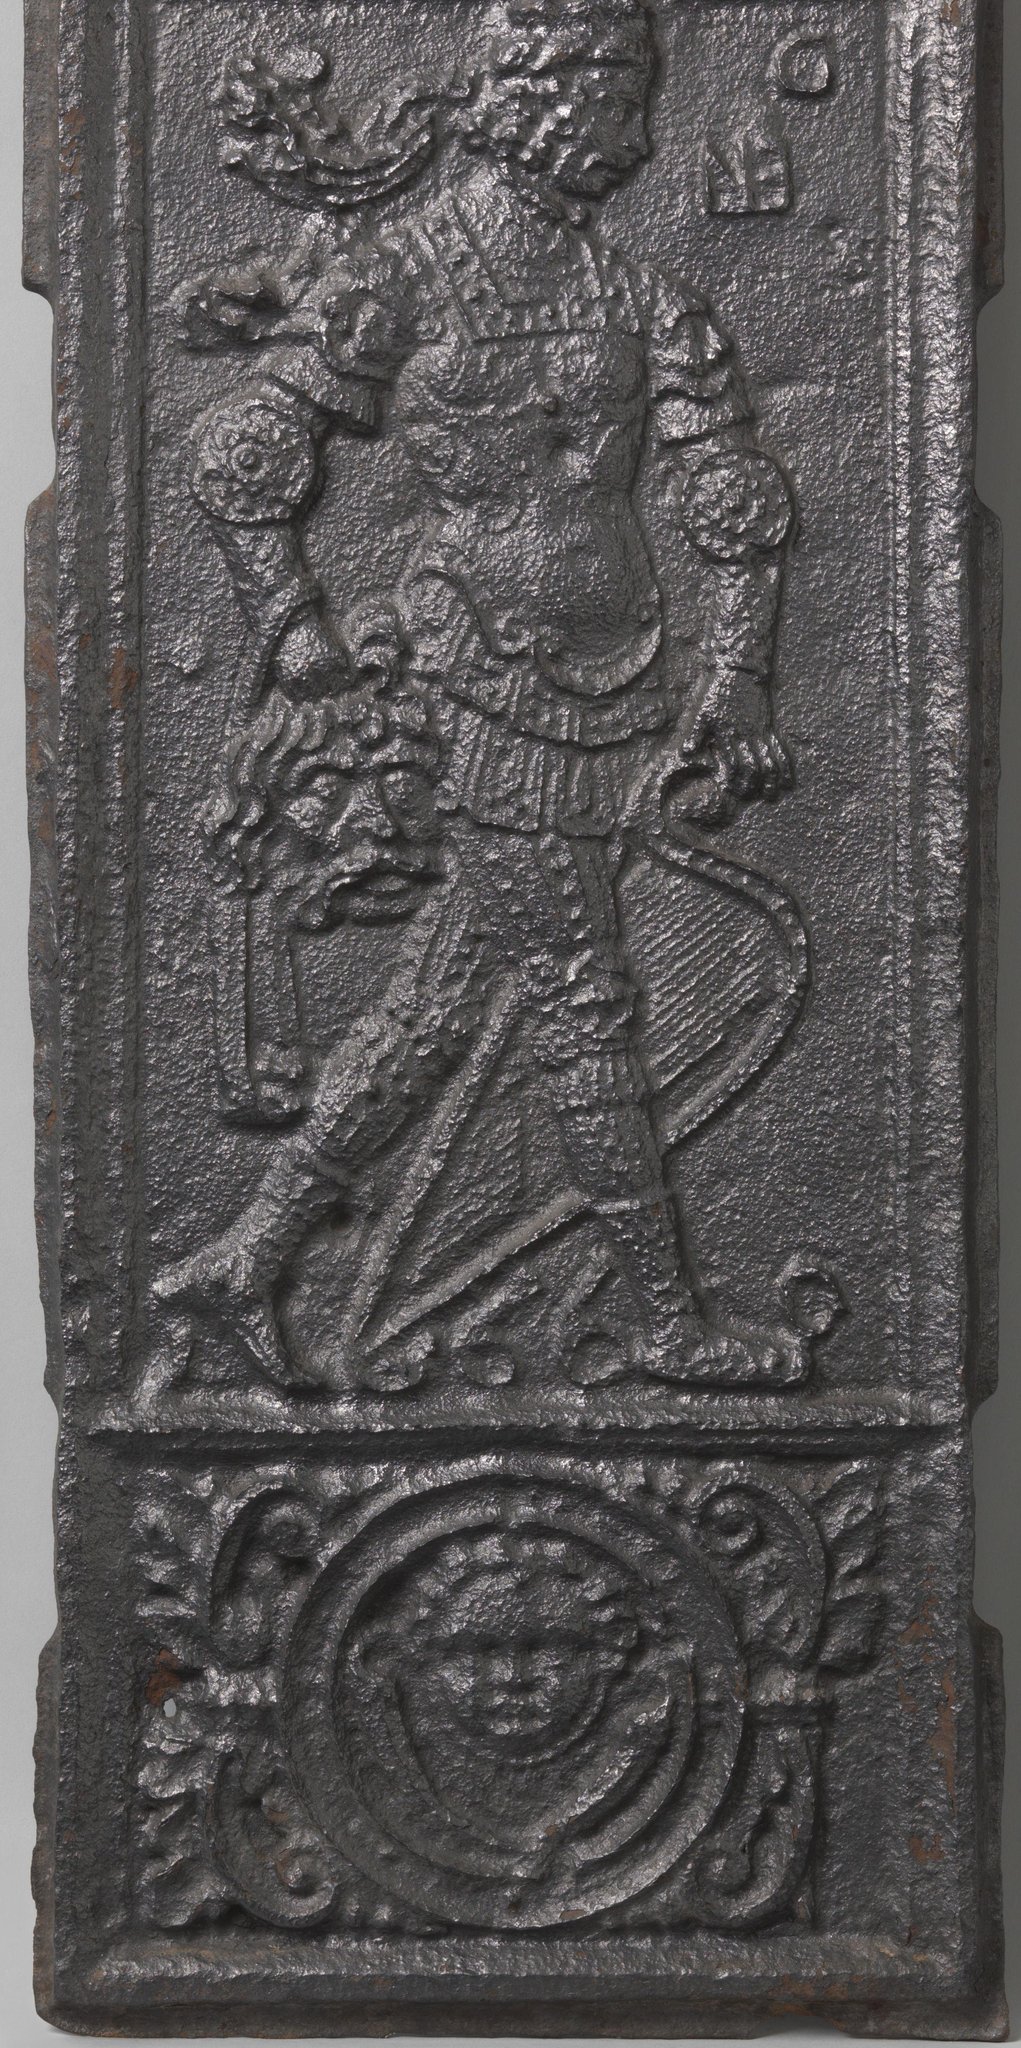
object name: stove plate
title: Kachelplaat met koning David met het hoofd van Goliath.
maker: Anonymous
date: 1660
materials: iron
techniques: casting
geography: germany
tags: david with goliath's head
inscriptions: maker's mark: ‘G / NB’, inscription: ‘1660’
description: Kachelplaat van gietijzer, verdeeld in twee zones. Centraal in de bovenste zone staat koning David, naar rechts lopend, met in zijn rechterhand het hooft van Goliath en in zijn linkerhand een harp. De onderste zone heeft een gezicht in een medaillon omringd door ranken. Gemerkt: naast het hoofd van David de initialen G / NB en onder de voeten van David het jaartal 1660.